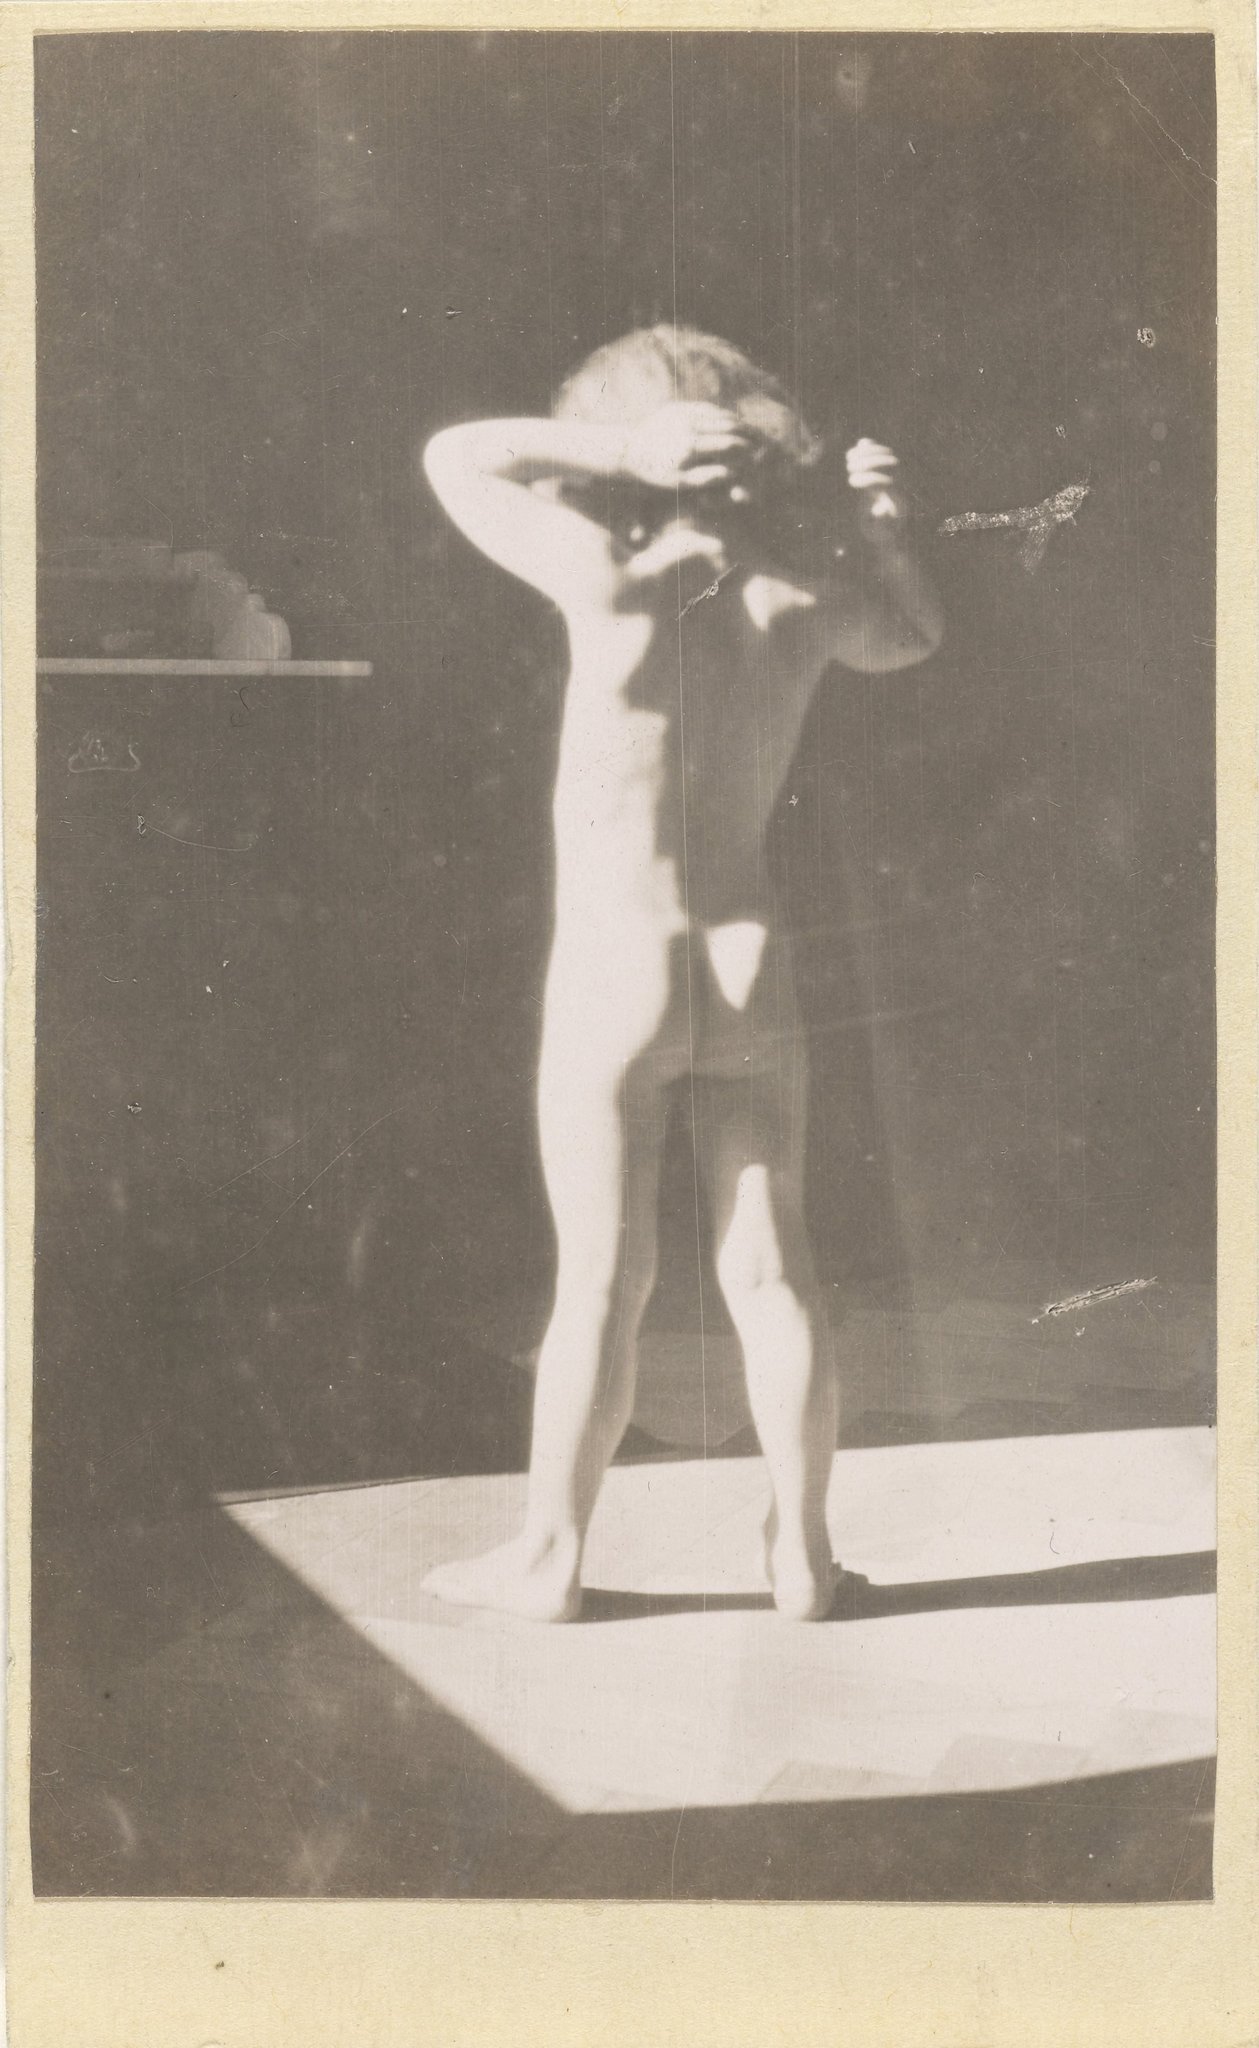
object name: photograph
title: Eckart Titzenthaler, zoon van de fotograaf, naakt op de rug gezien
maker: waldemar titzenthaler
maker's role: fotograaf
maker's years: 1869-1937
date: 1915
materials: paper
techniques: collodion silver print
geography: germany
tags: girl (child between toddler and youth), germany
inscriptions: date: ‘4.6.15’